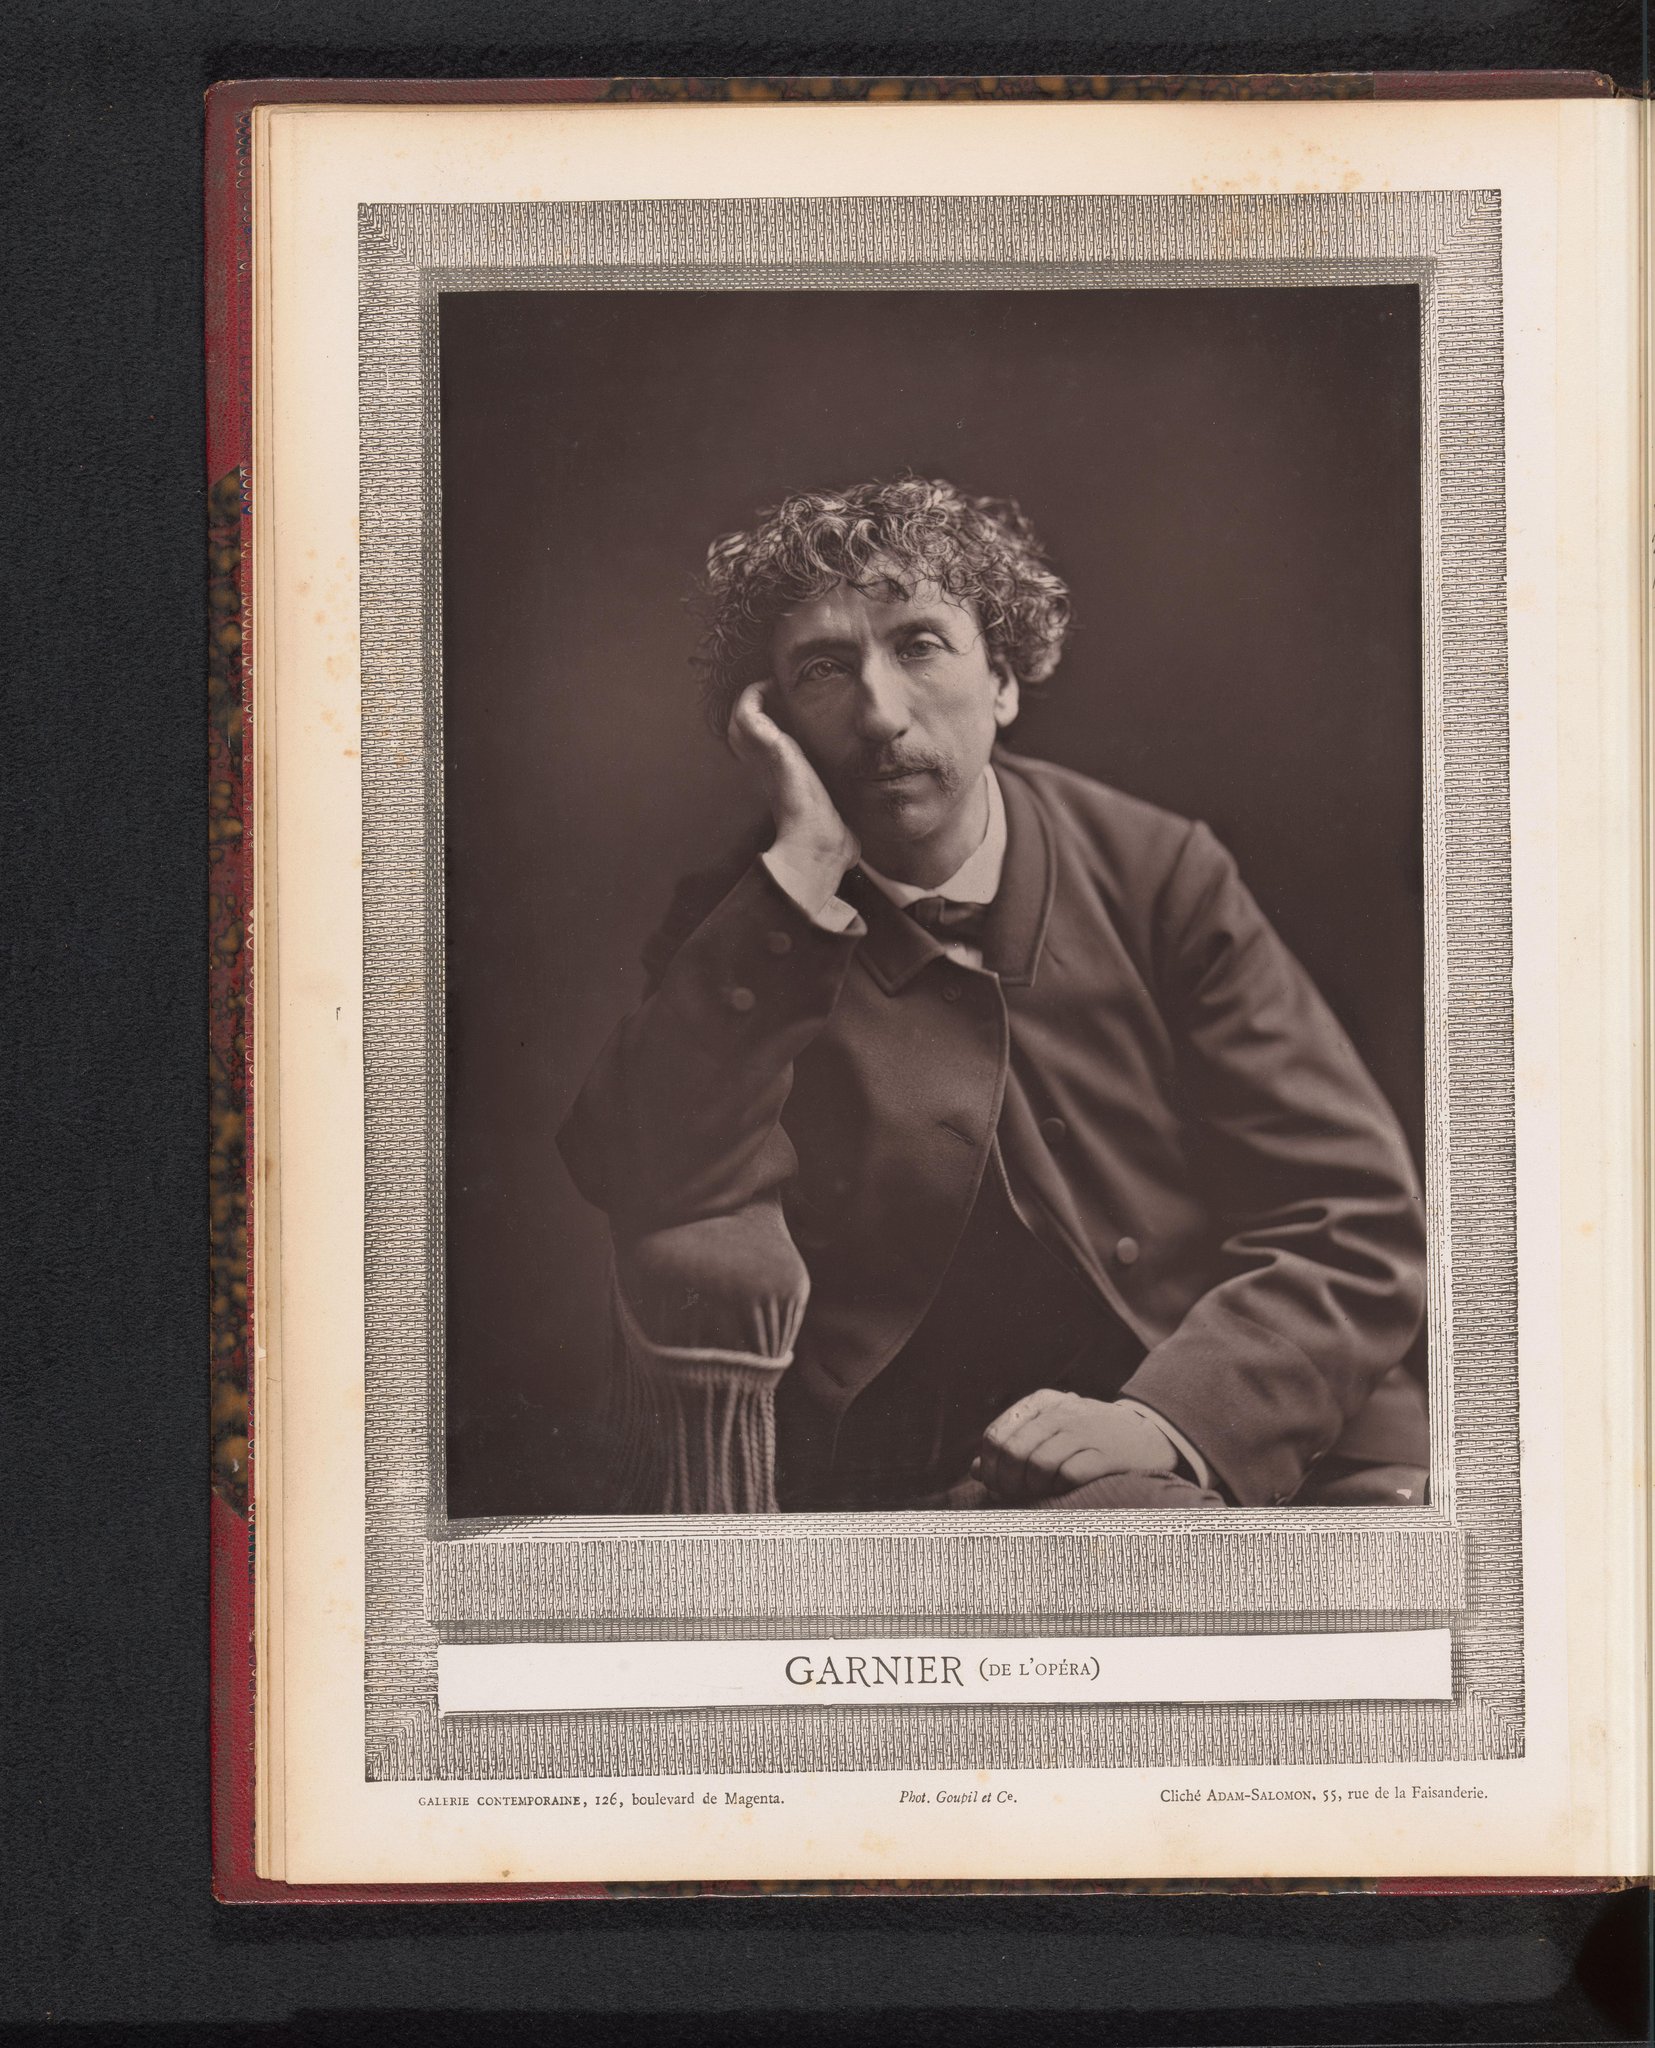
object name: page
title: Ch. Garnier (de l'opéra)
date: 1872-1877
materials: paper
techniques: woodburytype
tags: adult man, historical persons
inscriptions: inscription: ‘Galerie Contemporaine, 126, boulevard de Magenta.’